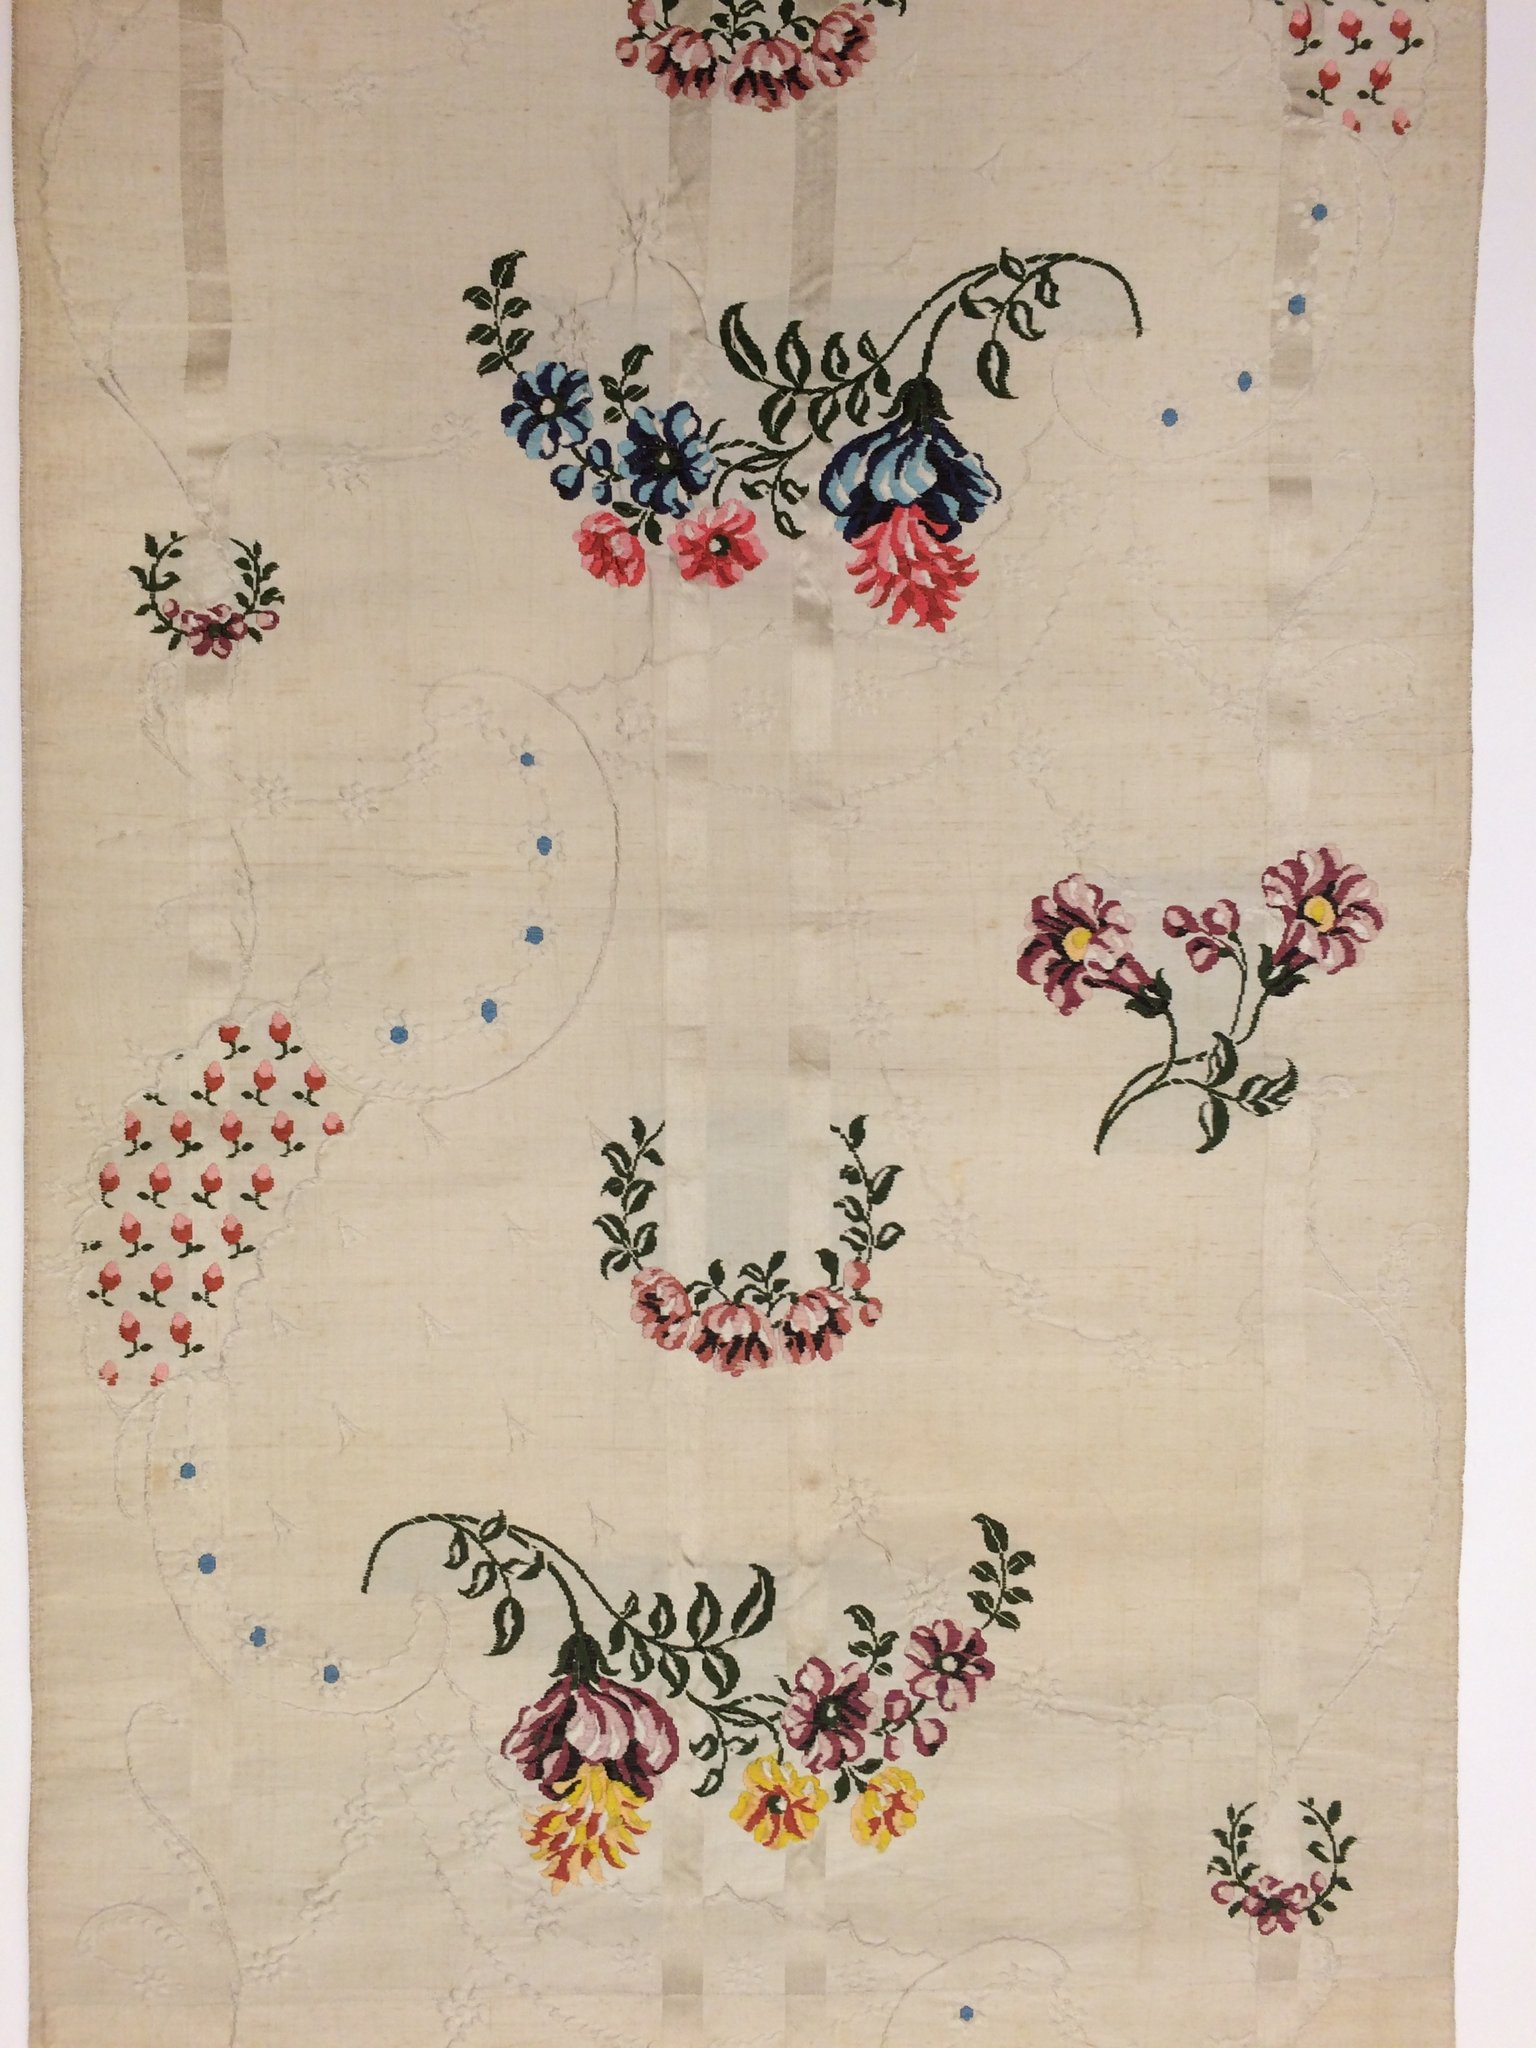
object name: panel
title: Skirt panel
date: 1760-1769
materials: silk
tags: flowers,leaves